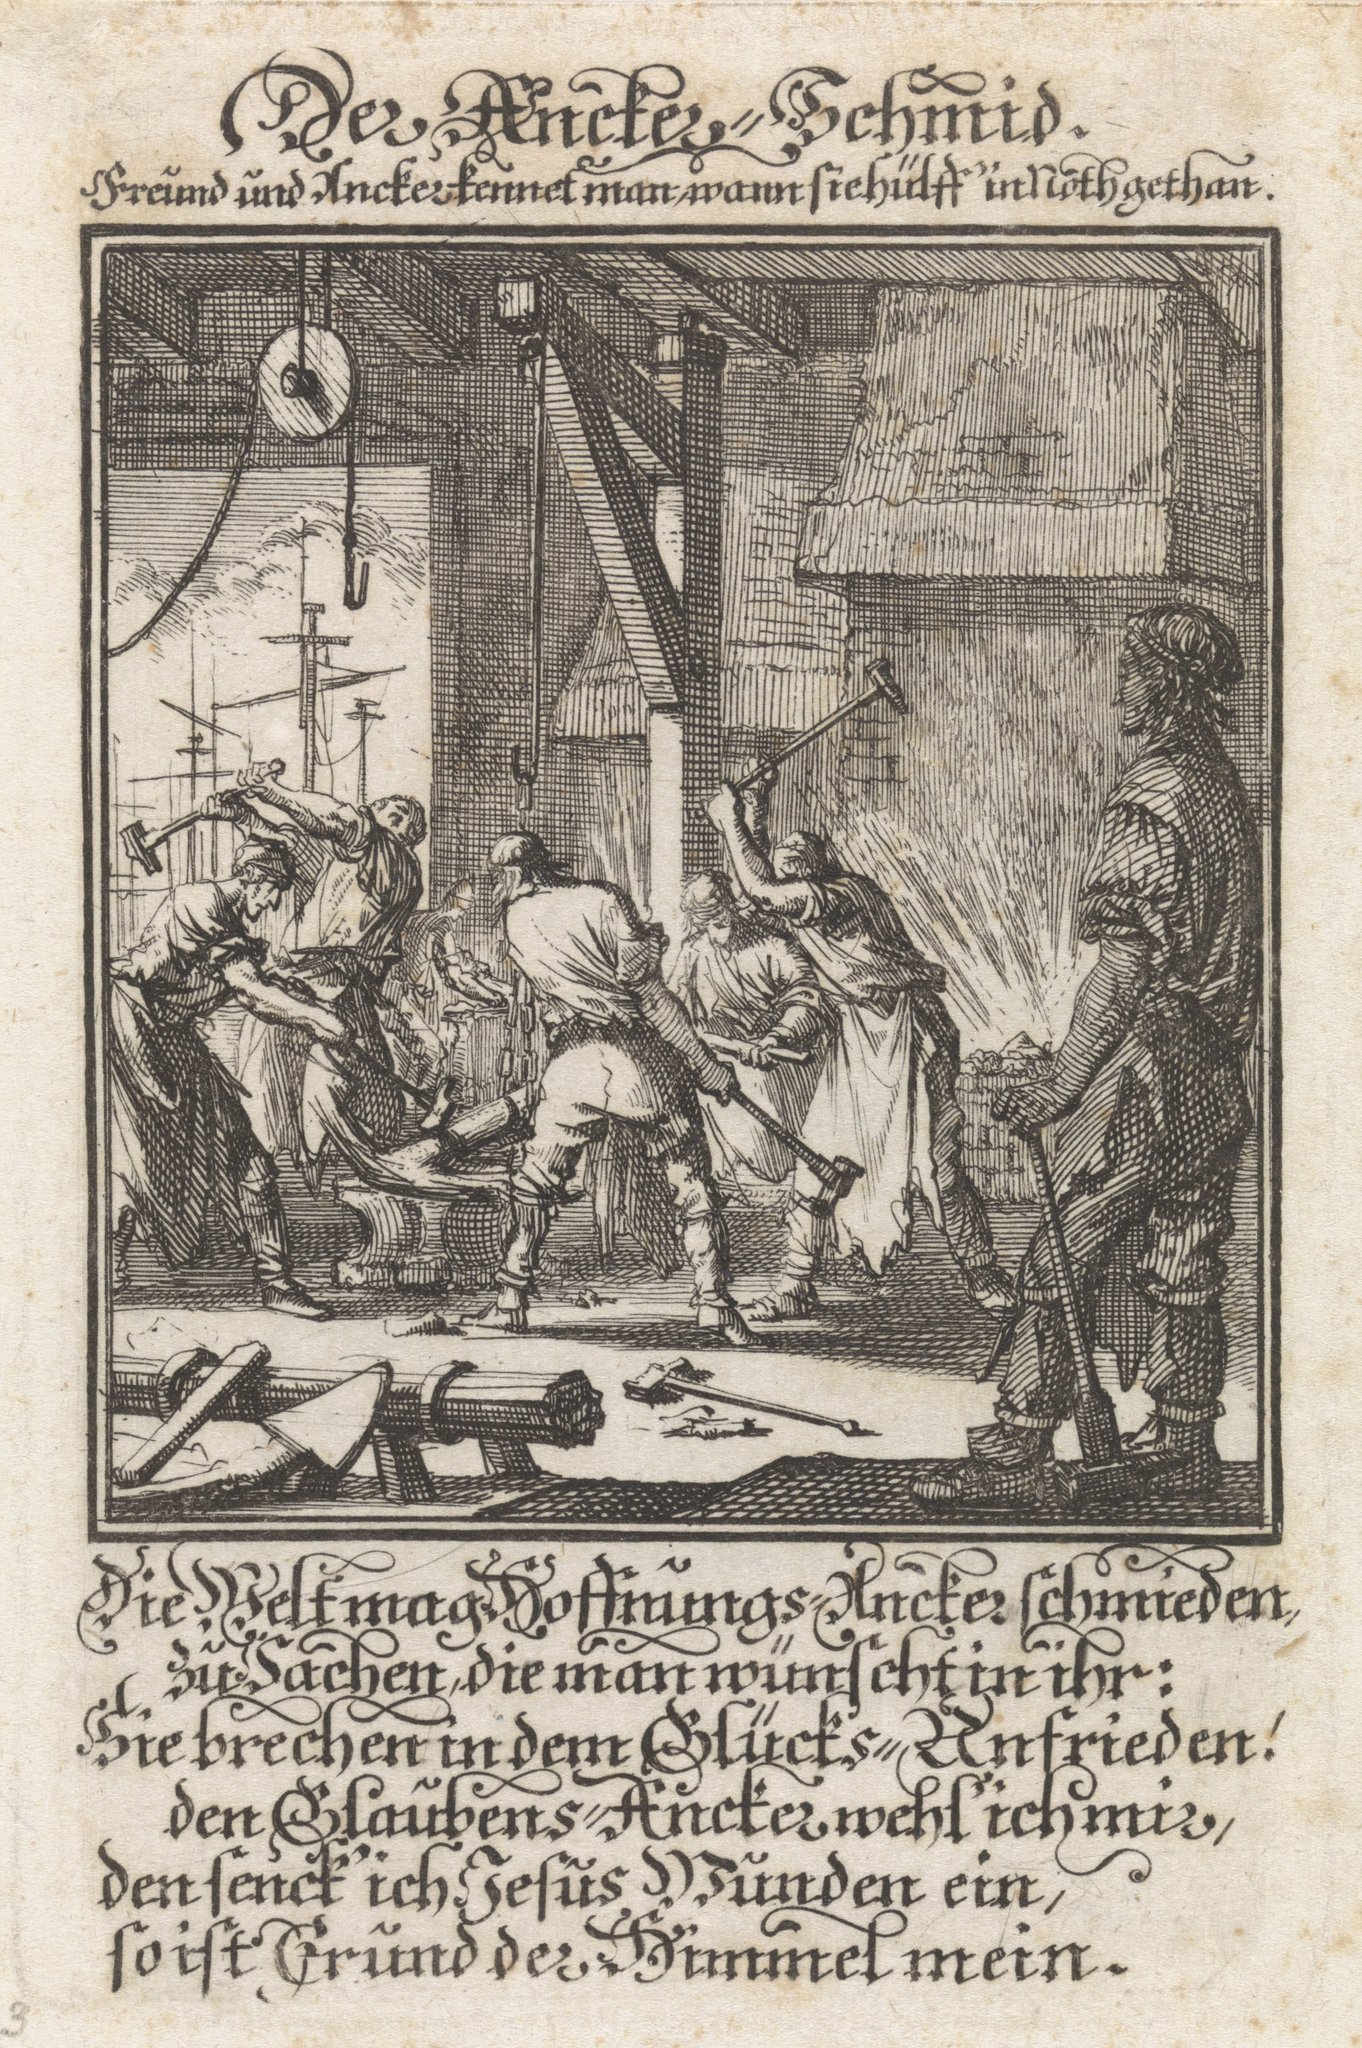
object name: print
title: Der Ancker-Schmid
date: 1698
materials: paper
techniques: etching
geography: amsterdam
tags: smith, blacksmith, parts of ship's exterior: anchor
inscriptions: number: ‘3’, collector's mark: Lugt 2228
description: Illustratie uit: Weigel, Christoff. Abbildung Der Gemein-Nützlichen Haupt-Stände Von denen Regenten Und ihren So in Friedens- als Kriegs-Zeiten zugeordneten Bedienten an, biß auf alle Künstler Und Handwercker. Regenspurg 1698, p. 99.